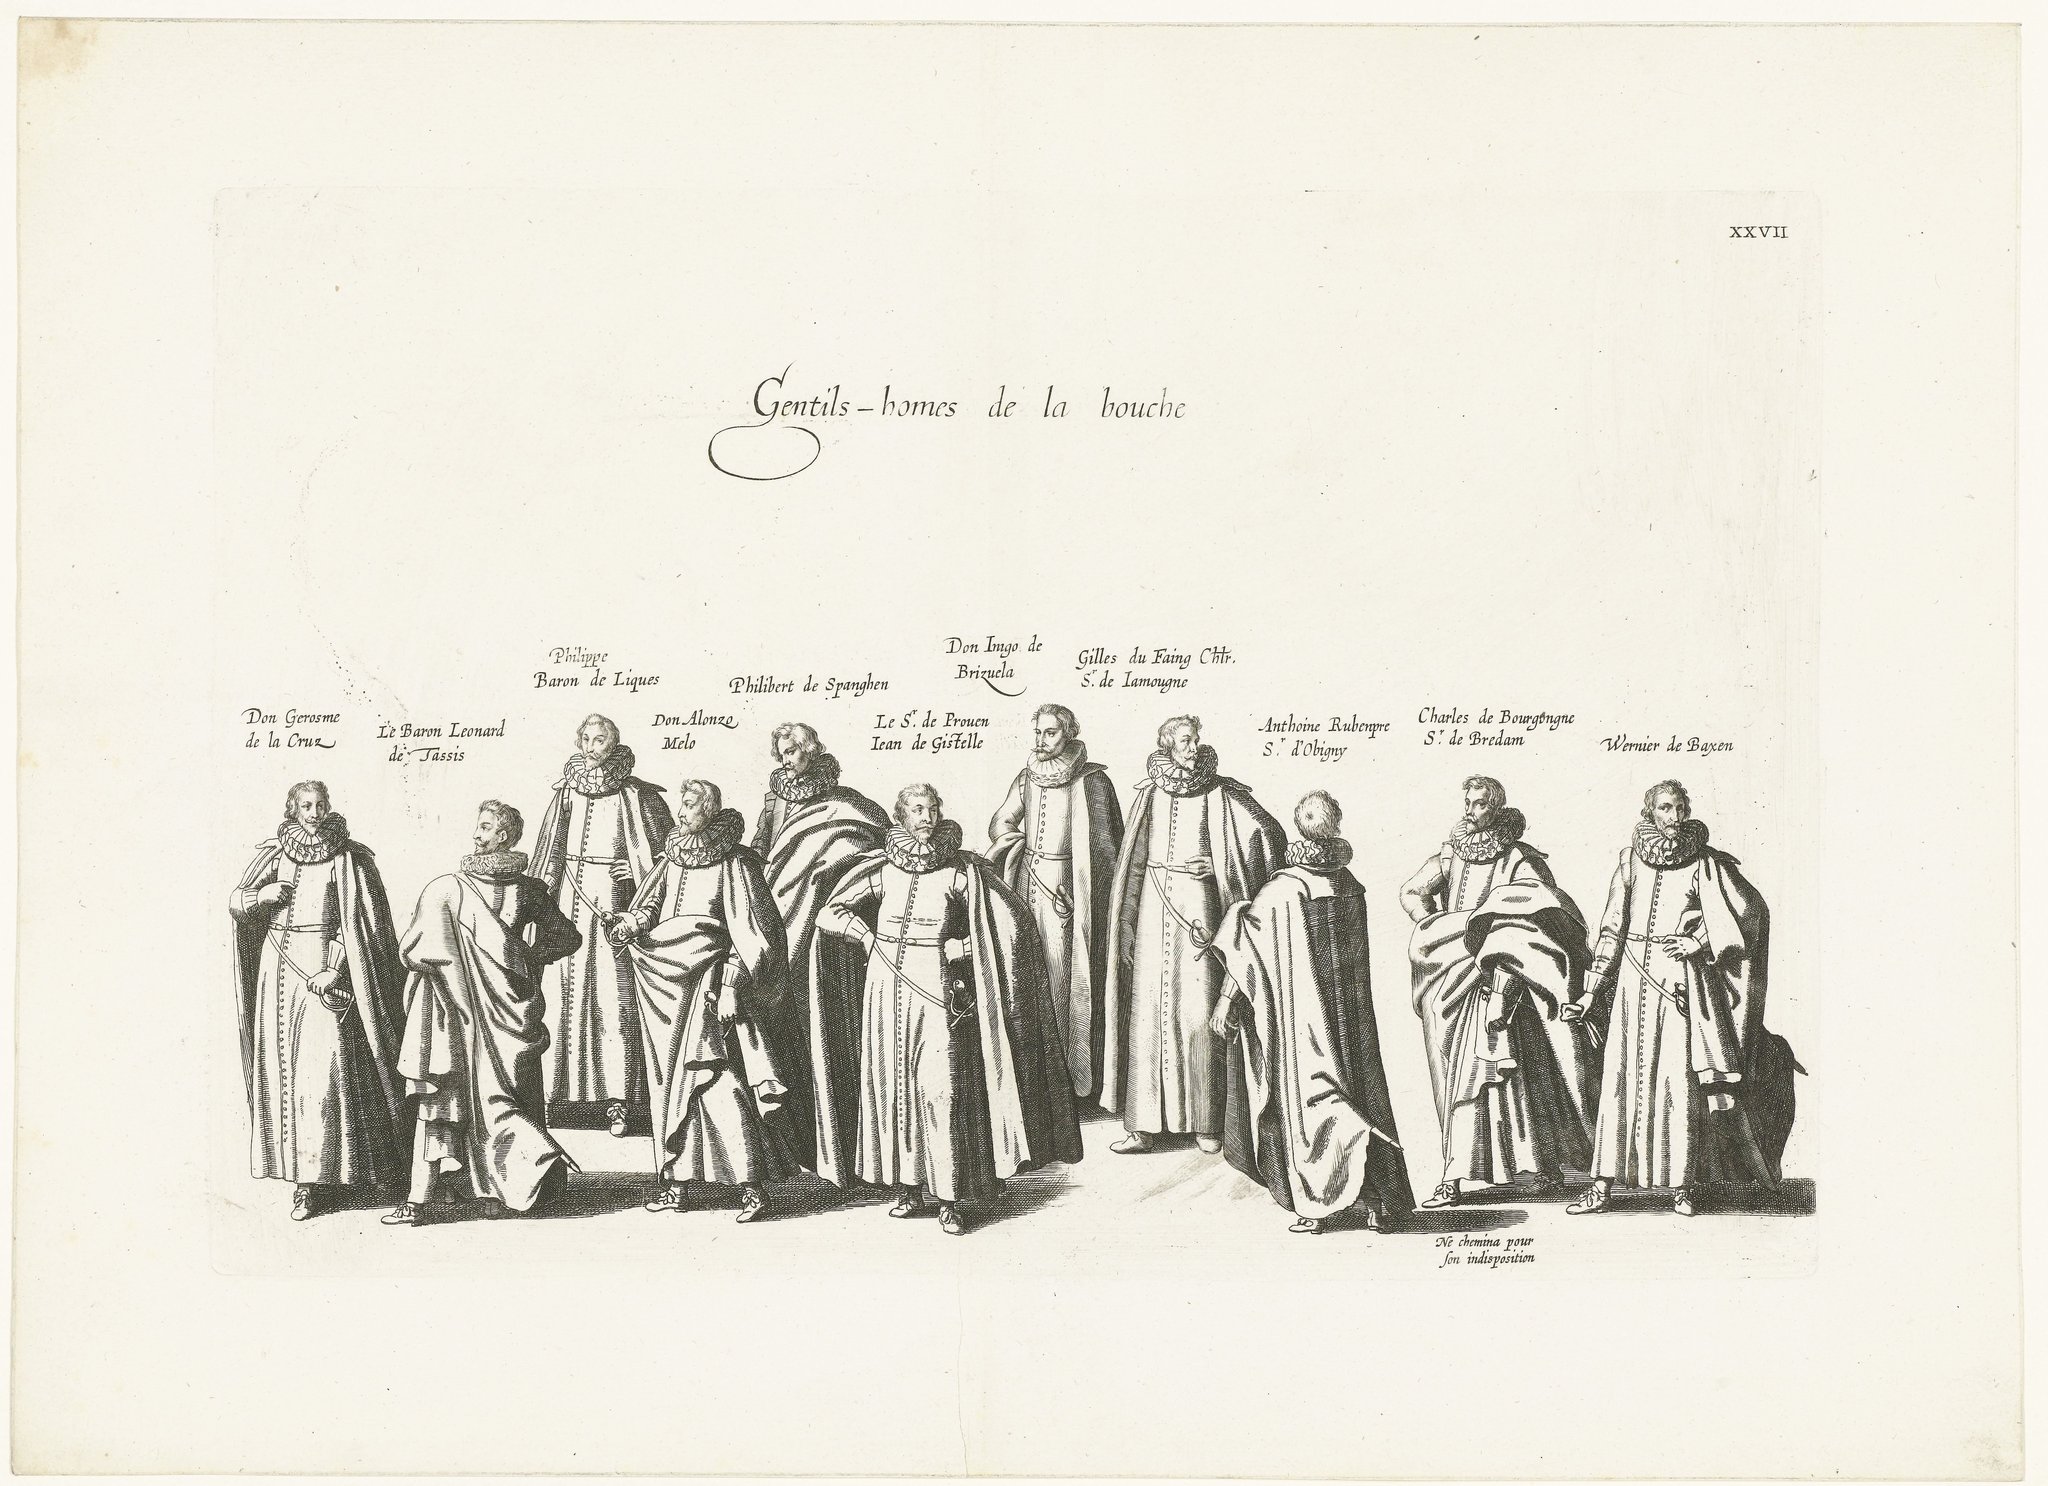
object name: print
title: Begrafenis van aartshertog Albrecht, 1622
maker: cornelis galle (i)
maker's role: print maker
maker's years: 1576-1650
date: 1623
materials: paper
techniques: etching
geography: southern netherlands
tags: brussels, albrecht aartshertog van oostenrijk, cortege, funeral procession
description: Deelnemers aan de begrafenisstoet. Plaat XXVII in de serie van de begrafenis van aartshertog Albrecht van Oostenrijk te Brussel op 12 maart 1622.